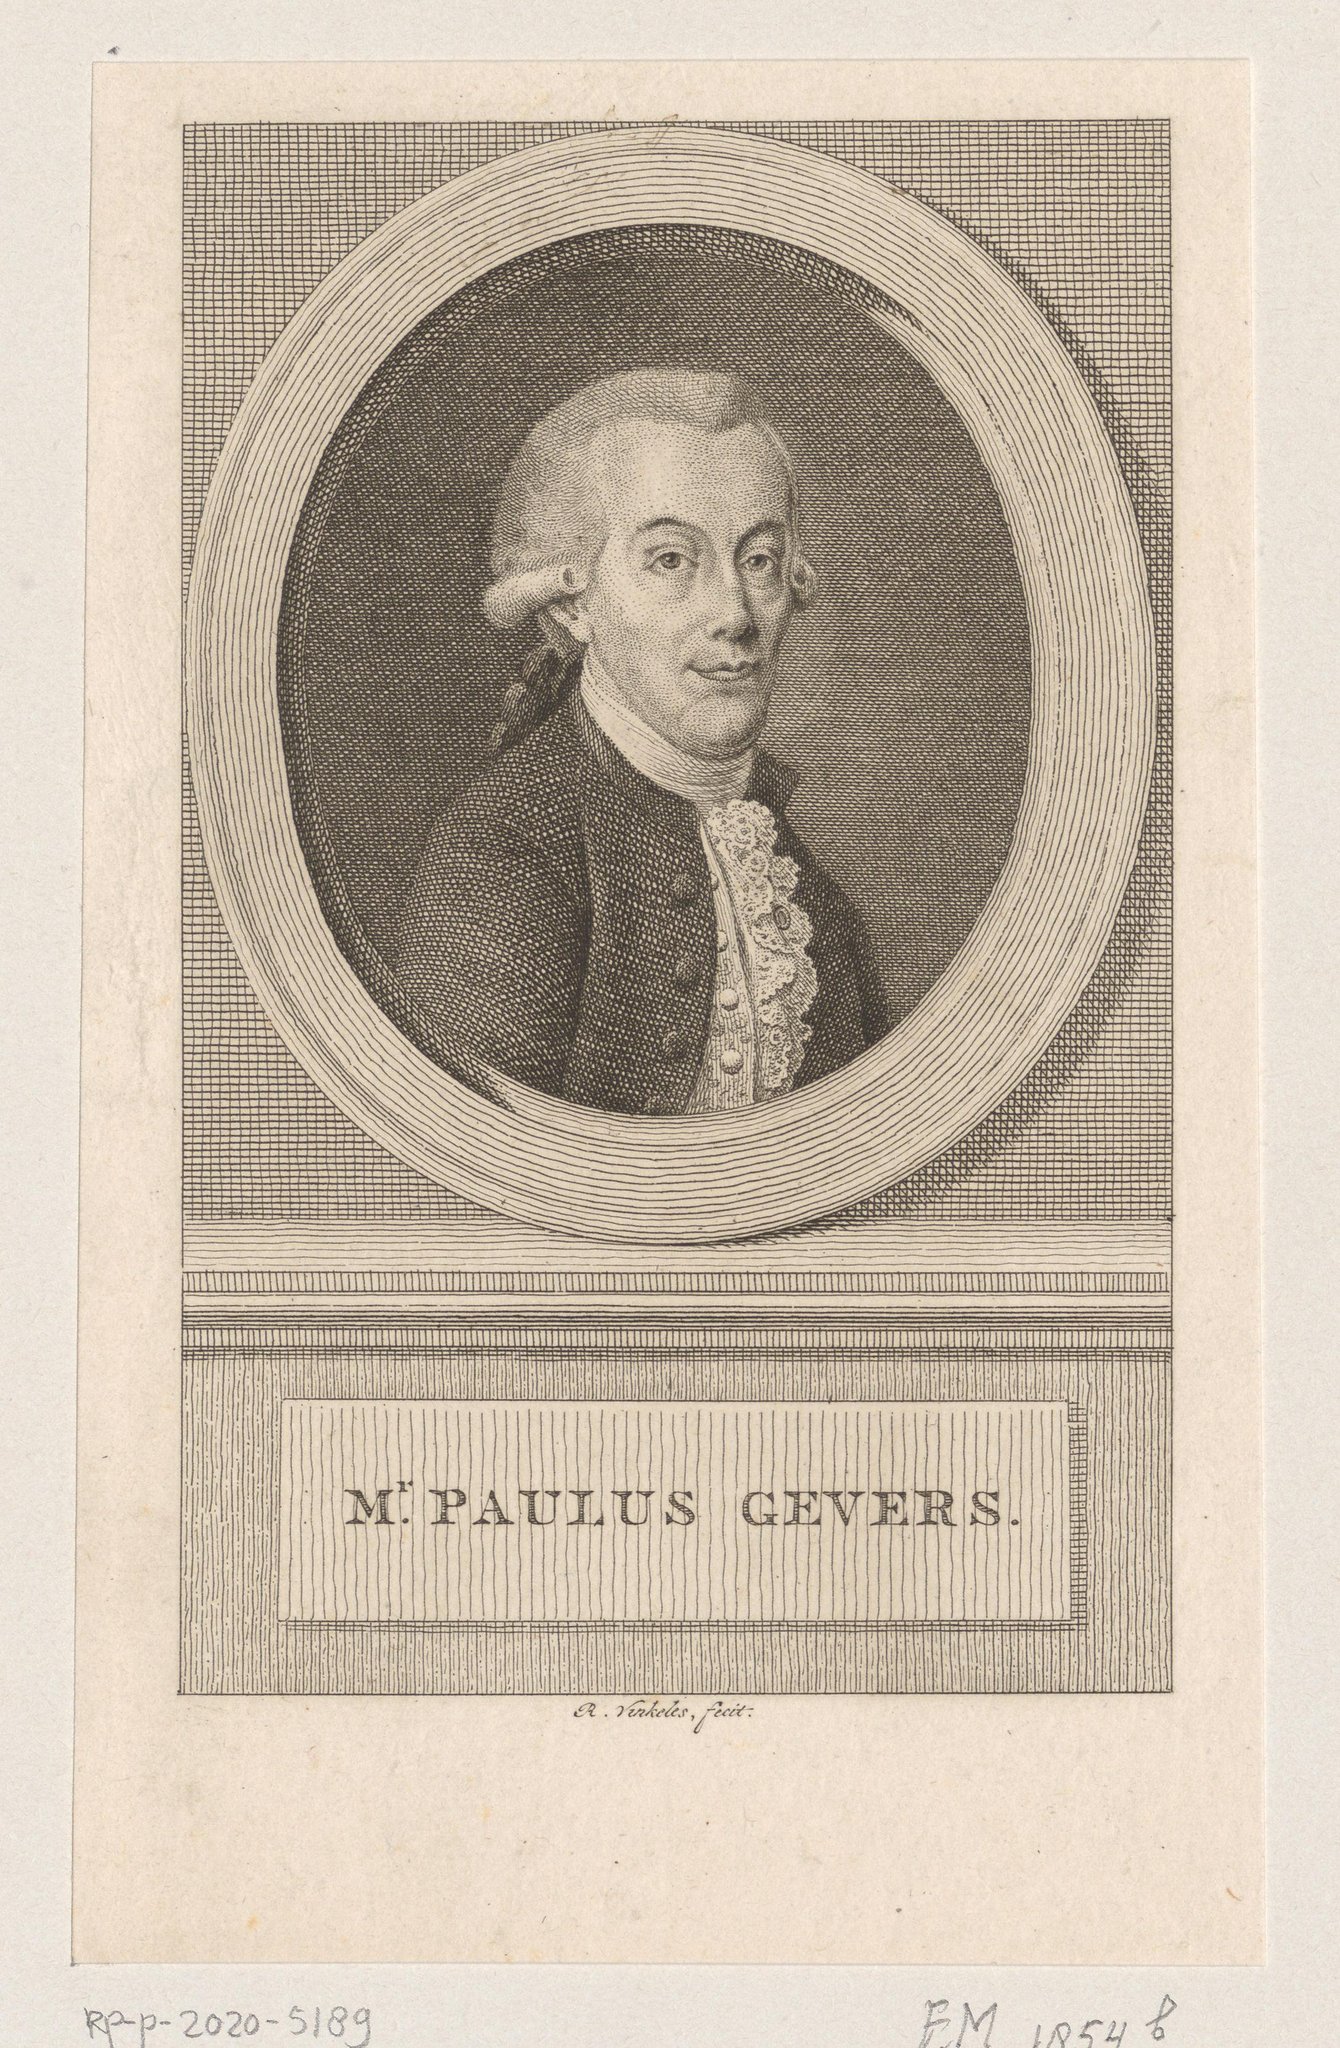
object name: print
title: Portret van Paulus Gevers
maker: reinier vinkeles (i)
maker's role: draughtsman, print maker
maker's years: 1741-1816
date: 1760-1786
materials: paper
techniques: engraving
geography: london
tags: rotterdam, historical persons, lawyer, attorney at law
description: Prent mogelijk uit: Wagenaar, Jan. Vaderlandsche historie, (...) ten vervolge van Wagenaars Vaderlandsche historie. 43 dln. Amsterdam: Johannes Allart, [1786-1809].